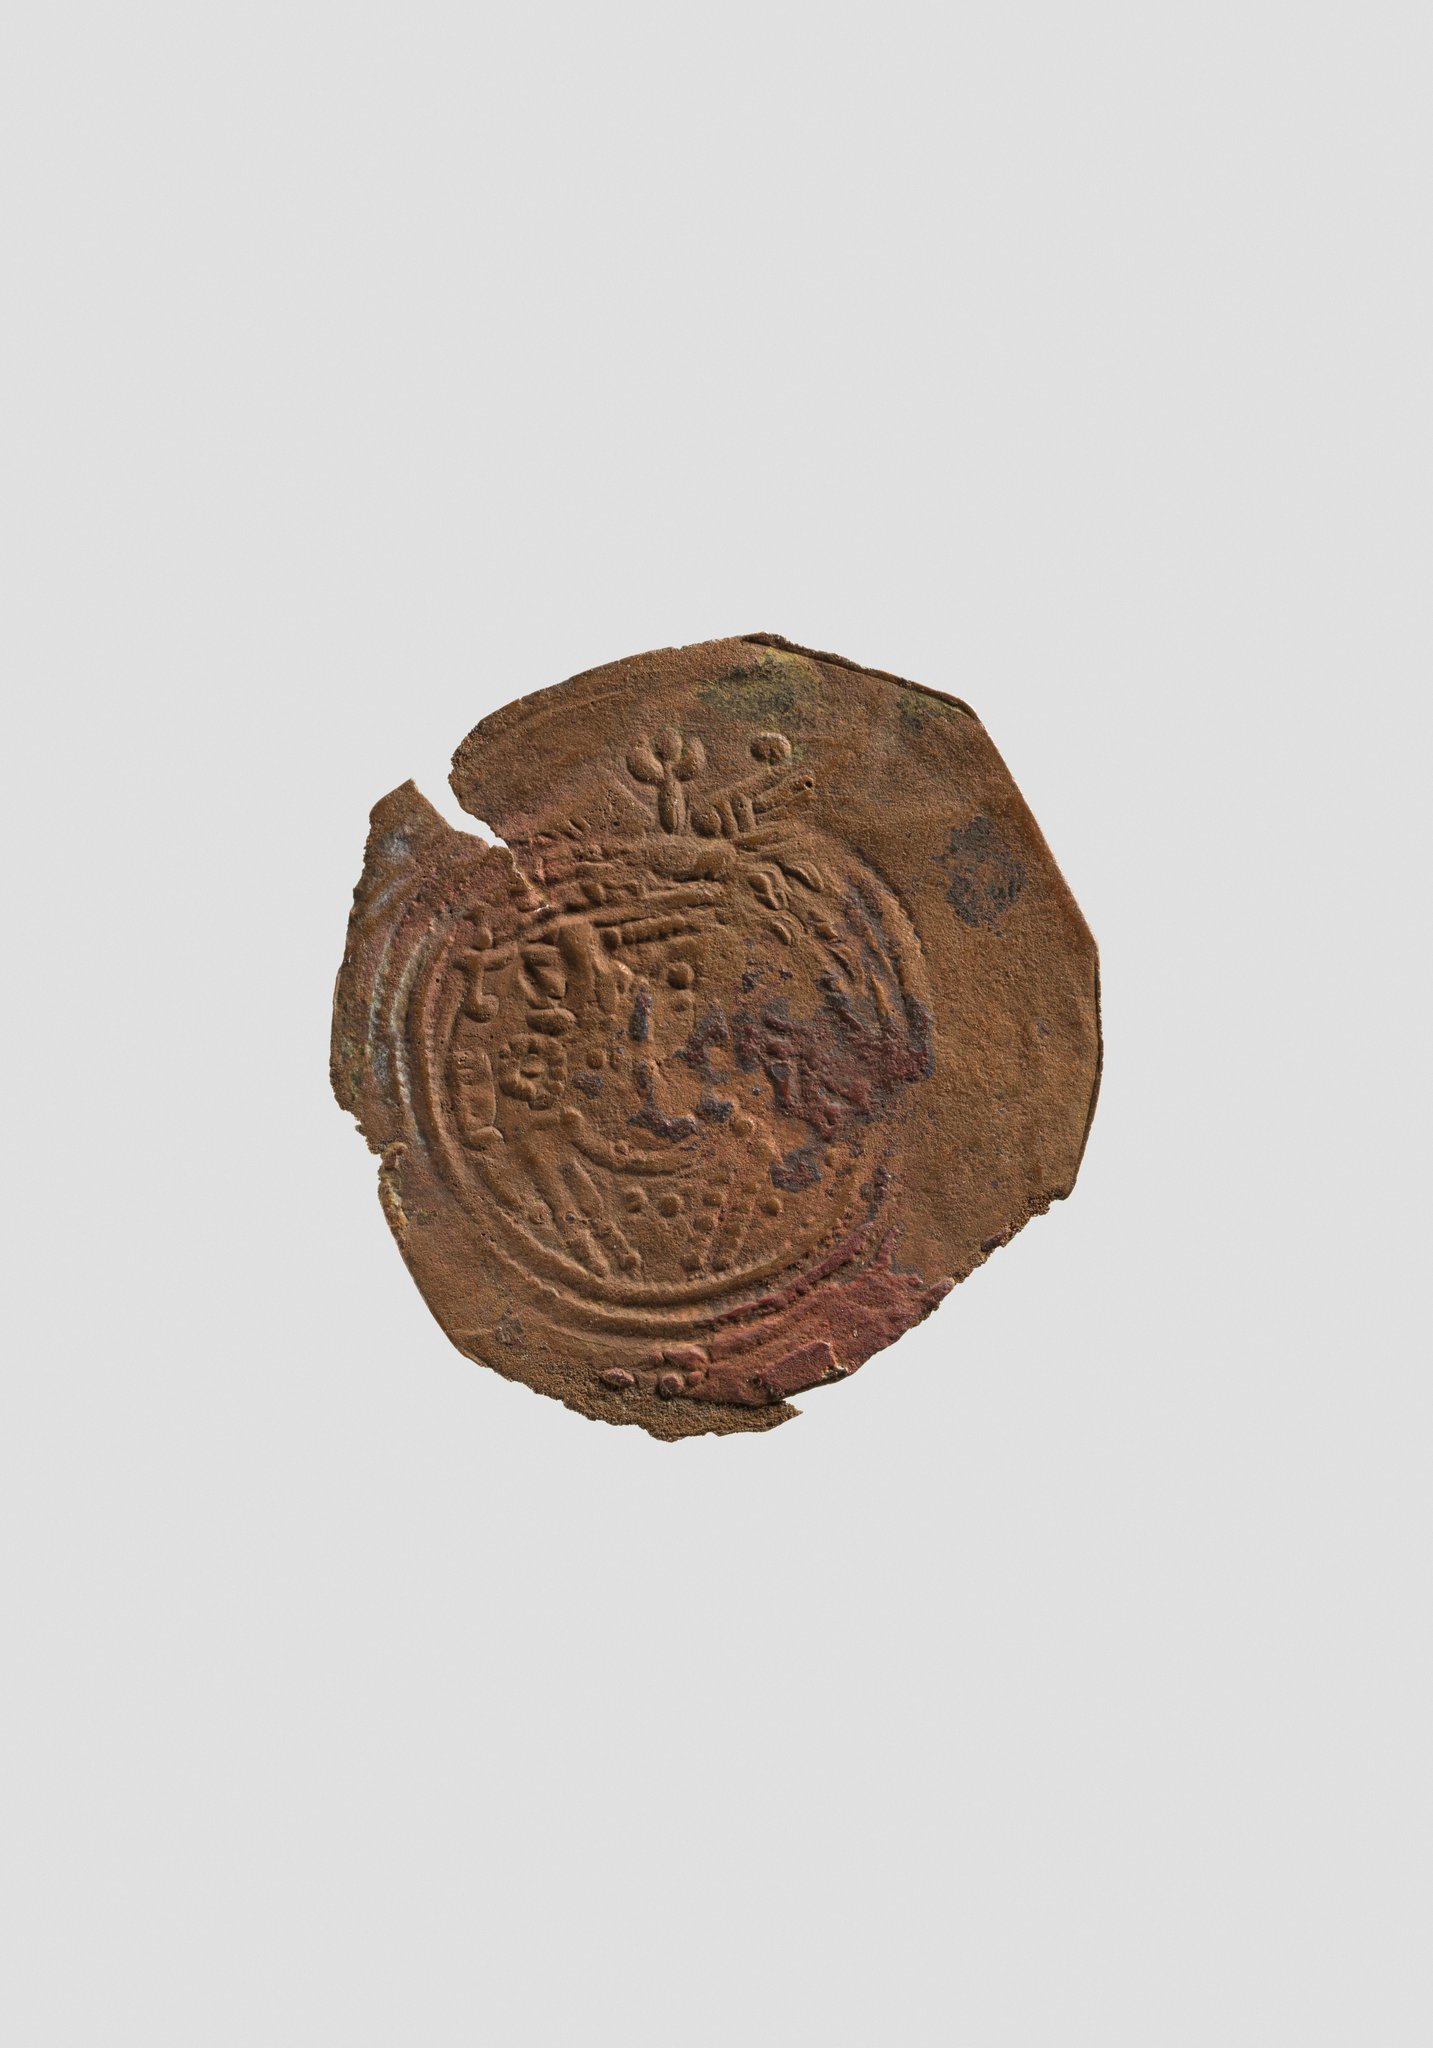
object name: coin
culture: islamic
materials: copper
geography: iran